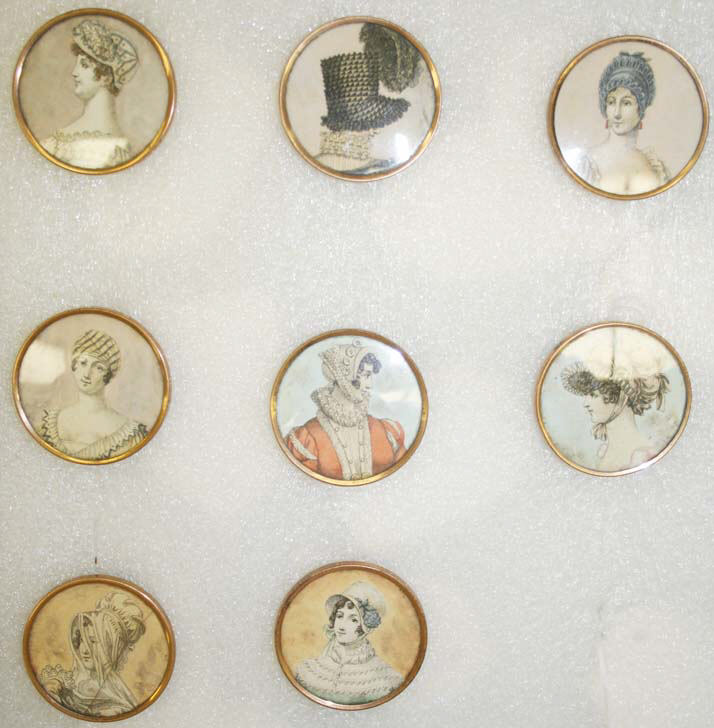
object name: button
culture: french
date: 1810-1819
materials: glass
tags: women